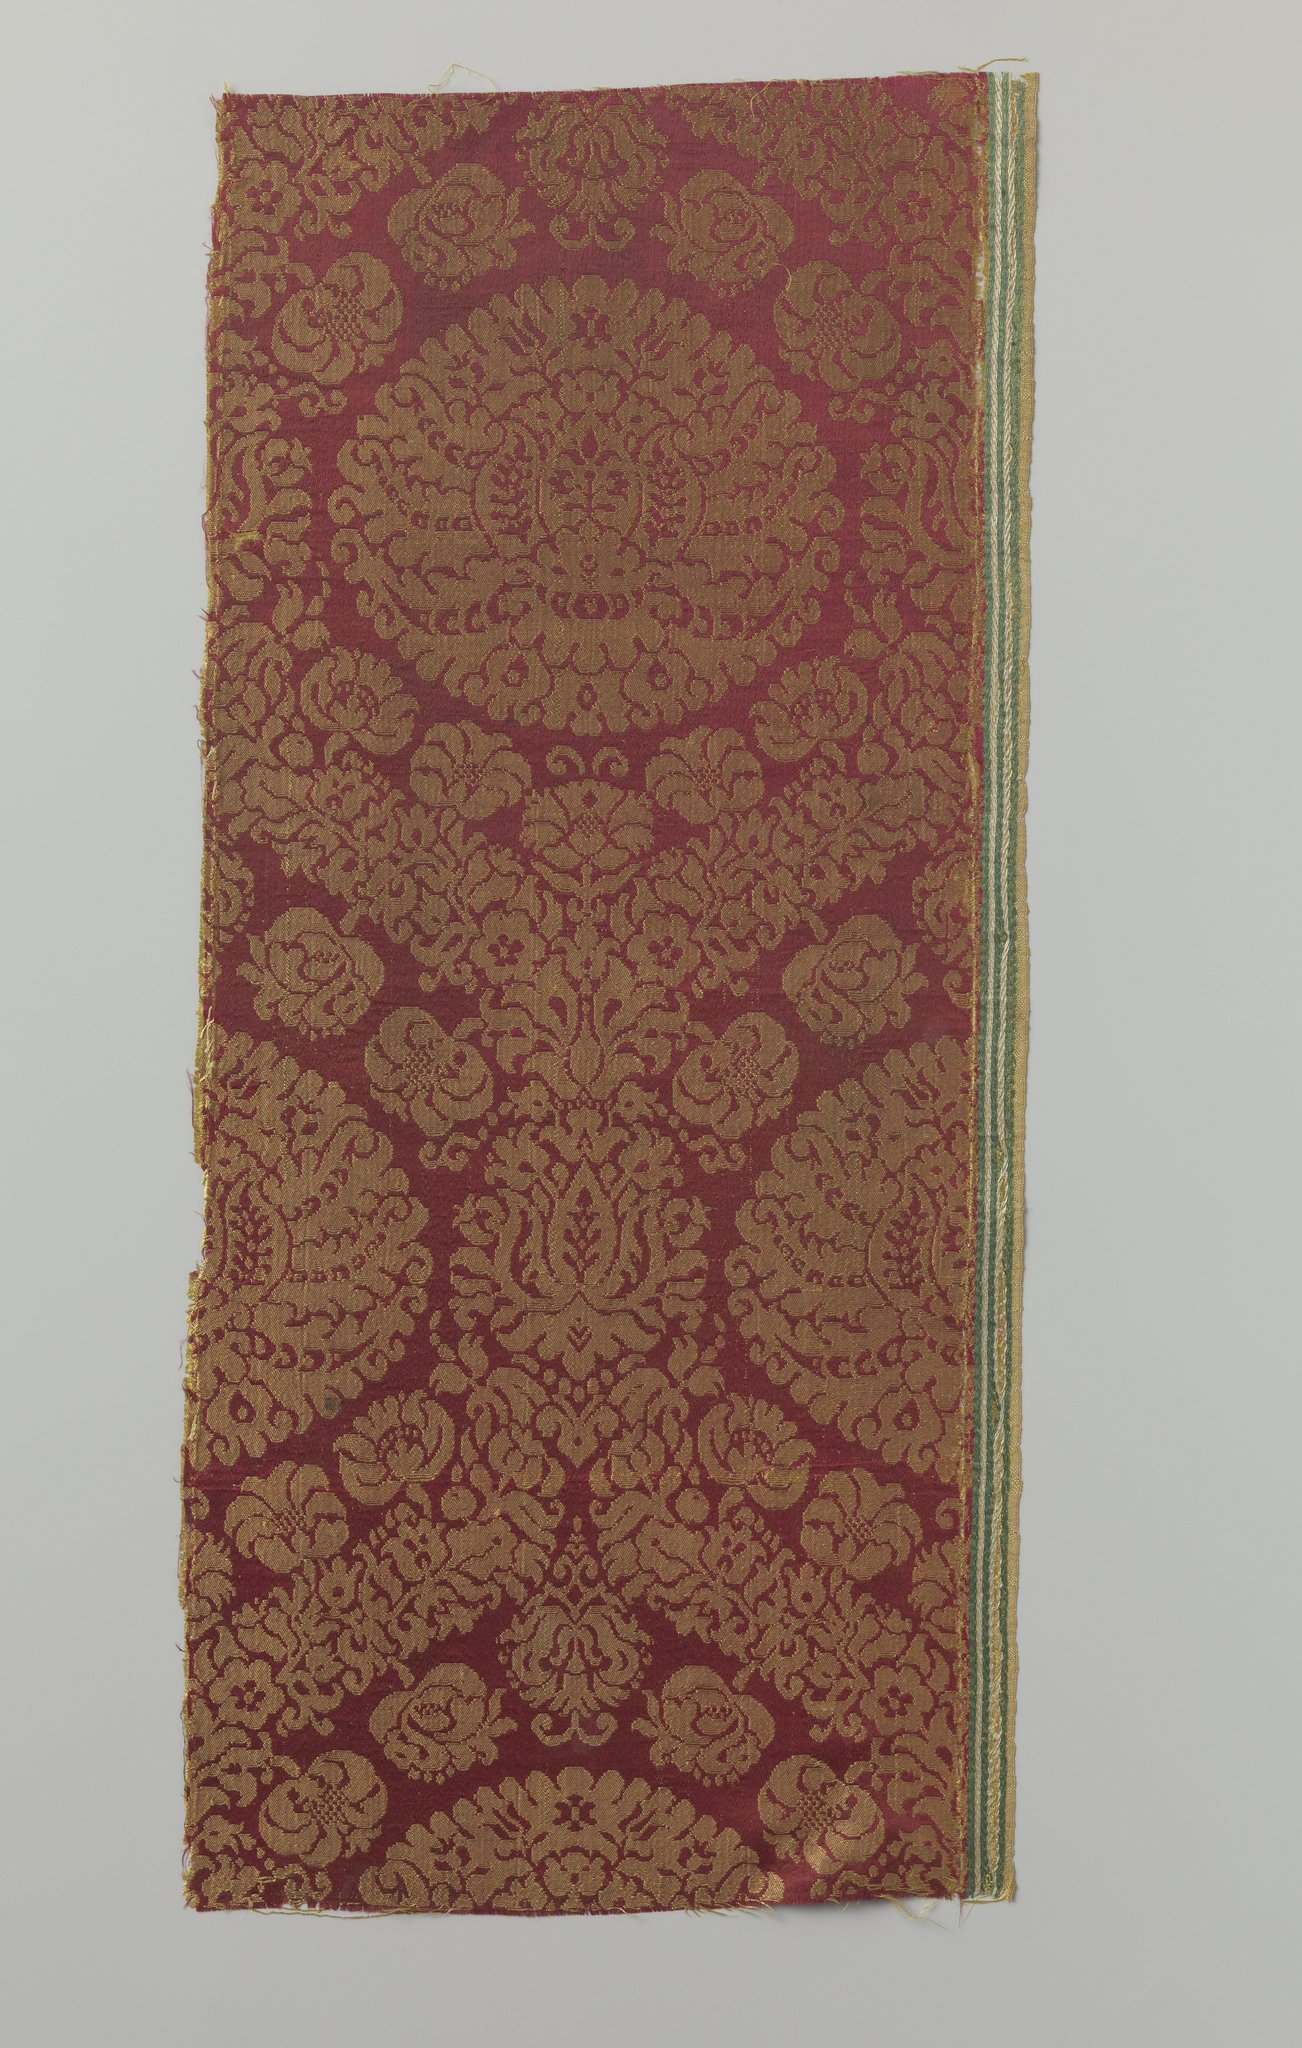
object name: zijdedamast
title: Fragment van rode en gele zijdedamast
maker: Anonymous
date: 1550-1599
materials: silk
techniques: damask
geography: italy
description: Fragment van rode en gele zijde met patroon van granaatappel in krans van rozeknoppen en bladeren.